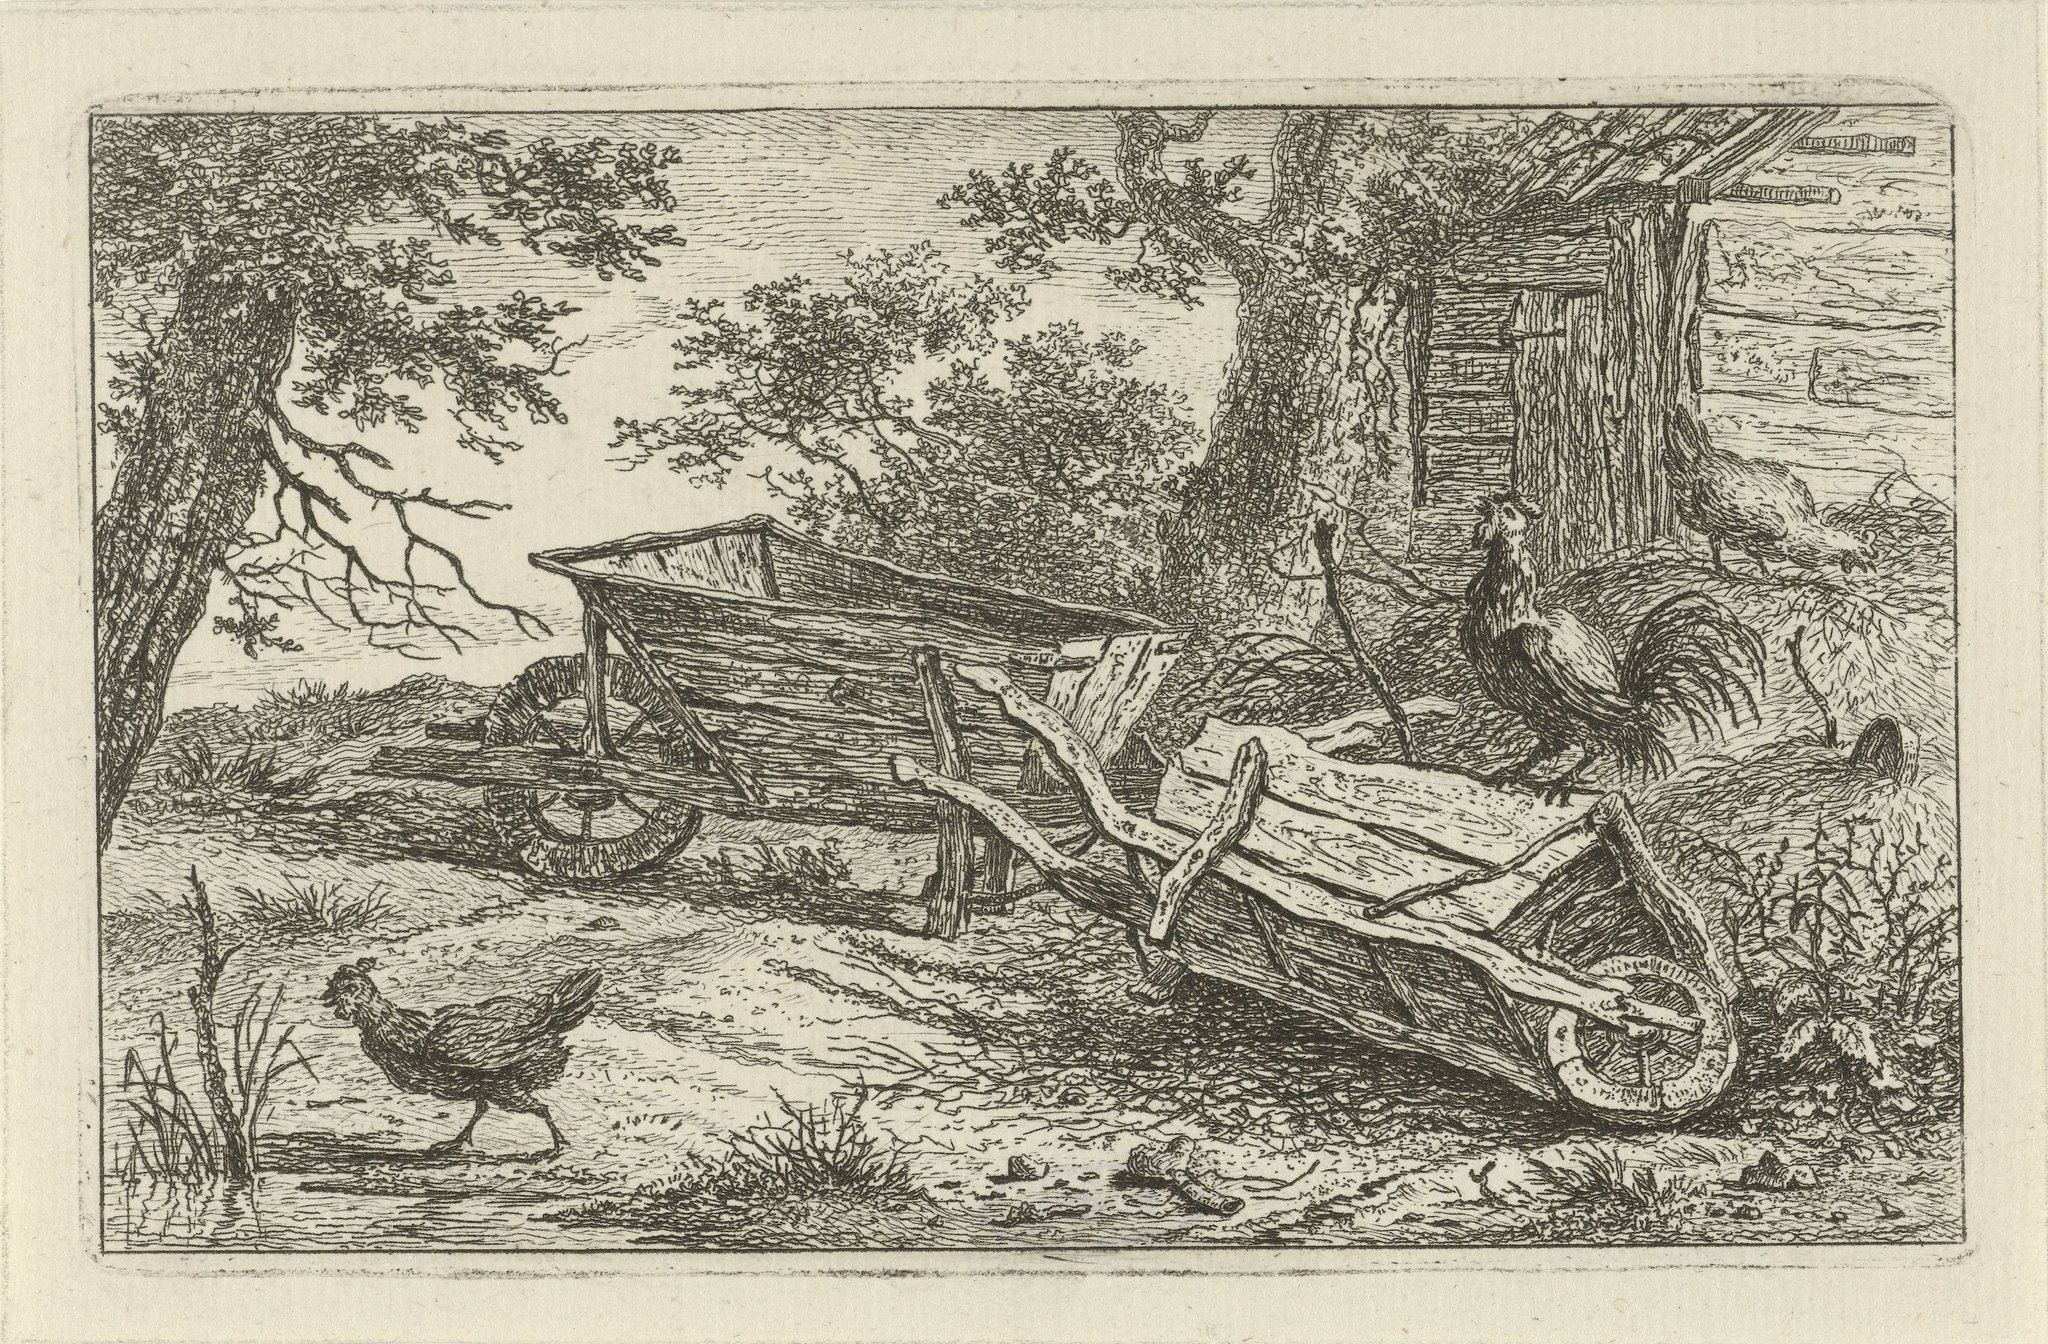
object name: print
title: Twee kruiwagens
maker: hermanus fock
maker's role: conservator, draughtsman, painter, print maker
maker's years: 1766-1822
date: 1781-1822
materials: paper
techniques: etching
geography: amsterdam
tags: wheelbarrow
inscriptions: collector's mark: Lugt 2228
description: Een gezicht op twee kruiwagens, twee kippen en een haan, bij een schuur. De haan staat op de omgevallen kruiwagen.